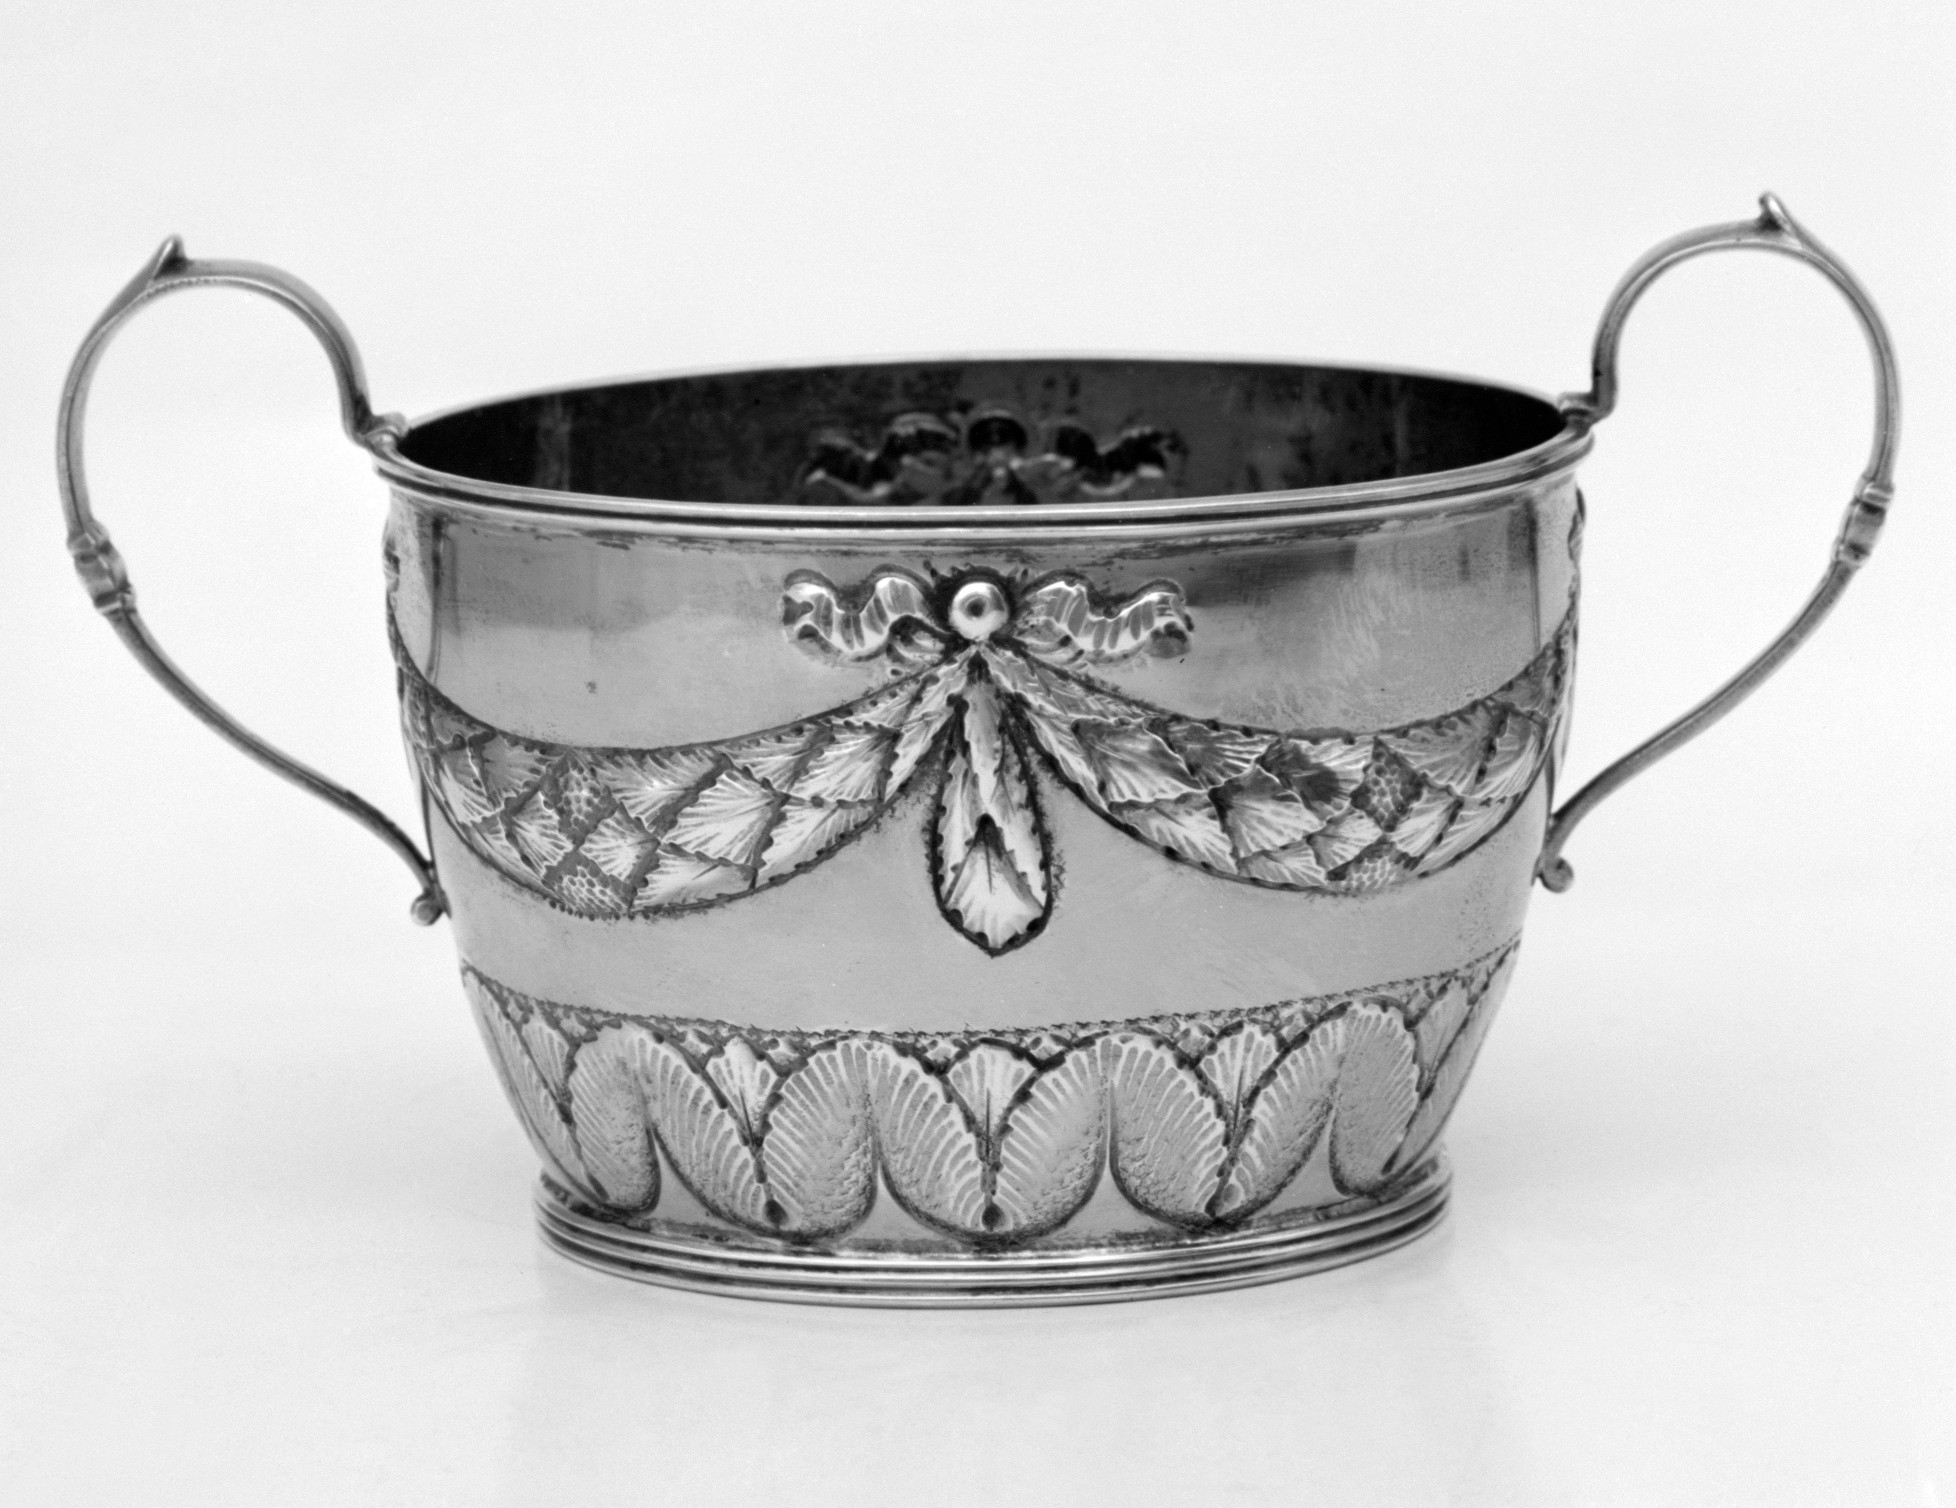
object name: sugar bowl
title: Sugar bowl (part of a set)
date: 1808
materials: silver gilt